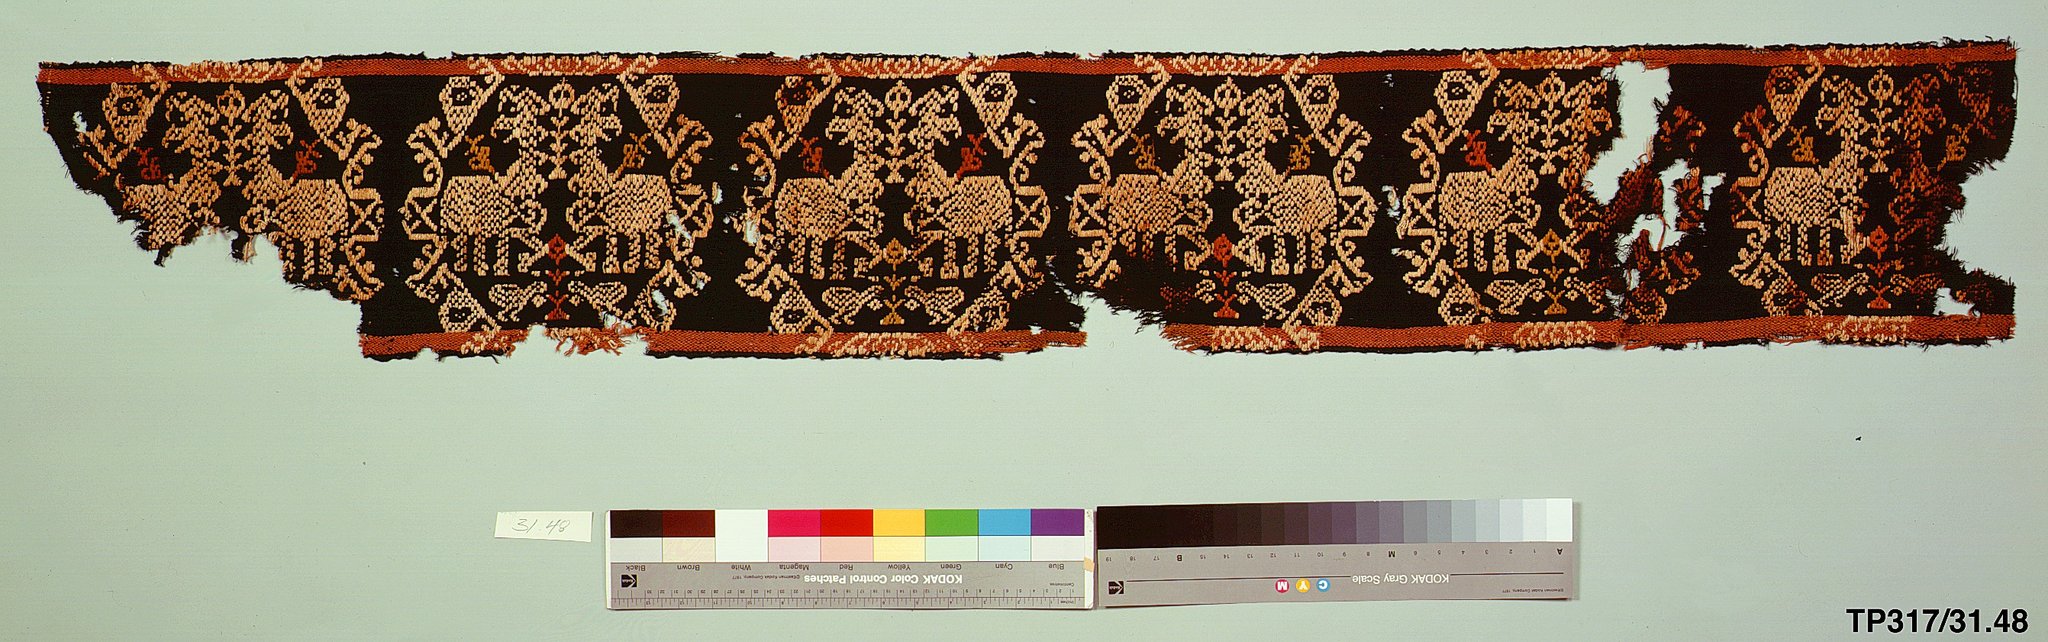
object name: band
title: Tunic Band with Repeating Motif of Confronted Griffins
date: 701-900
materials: linen, wool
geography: egypt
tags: griffins